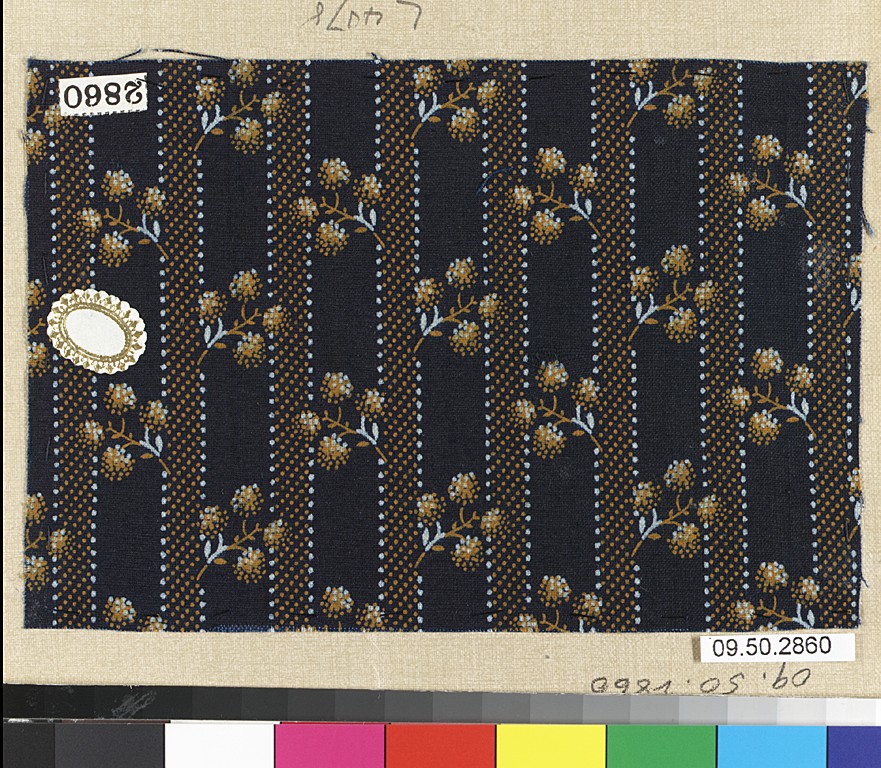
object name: piece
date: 1801-1900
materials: cotton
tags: flowers,leaves